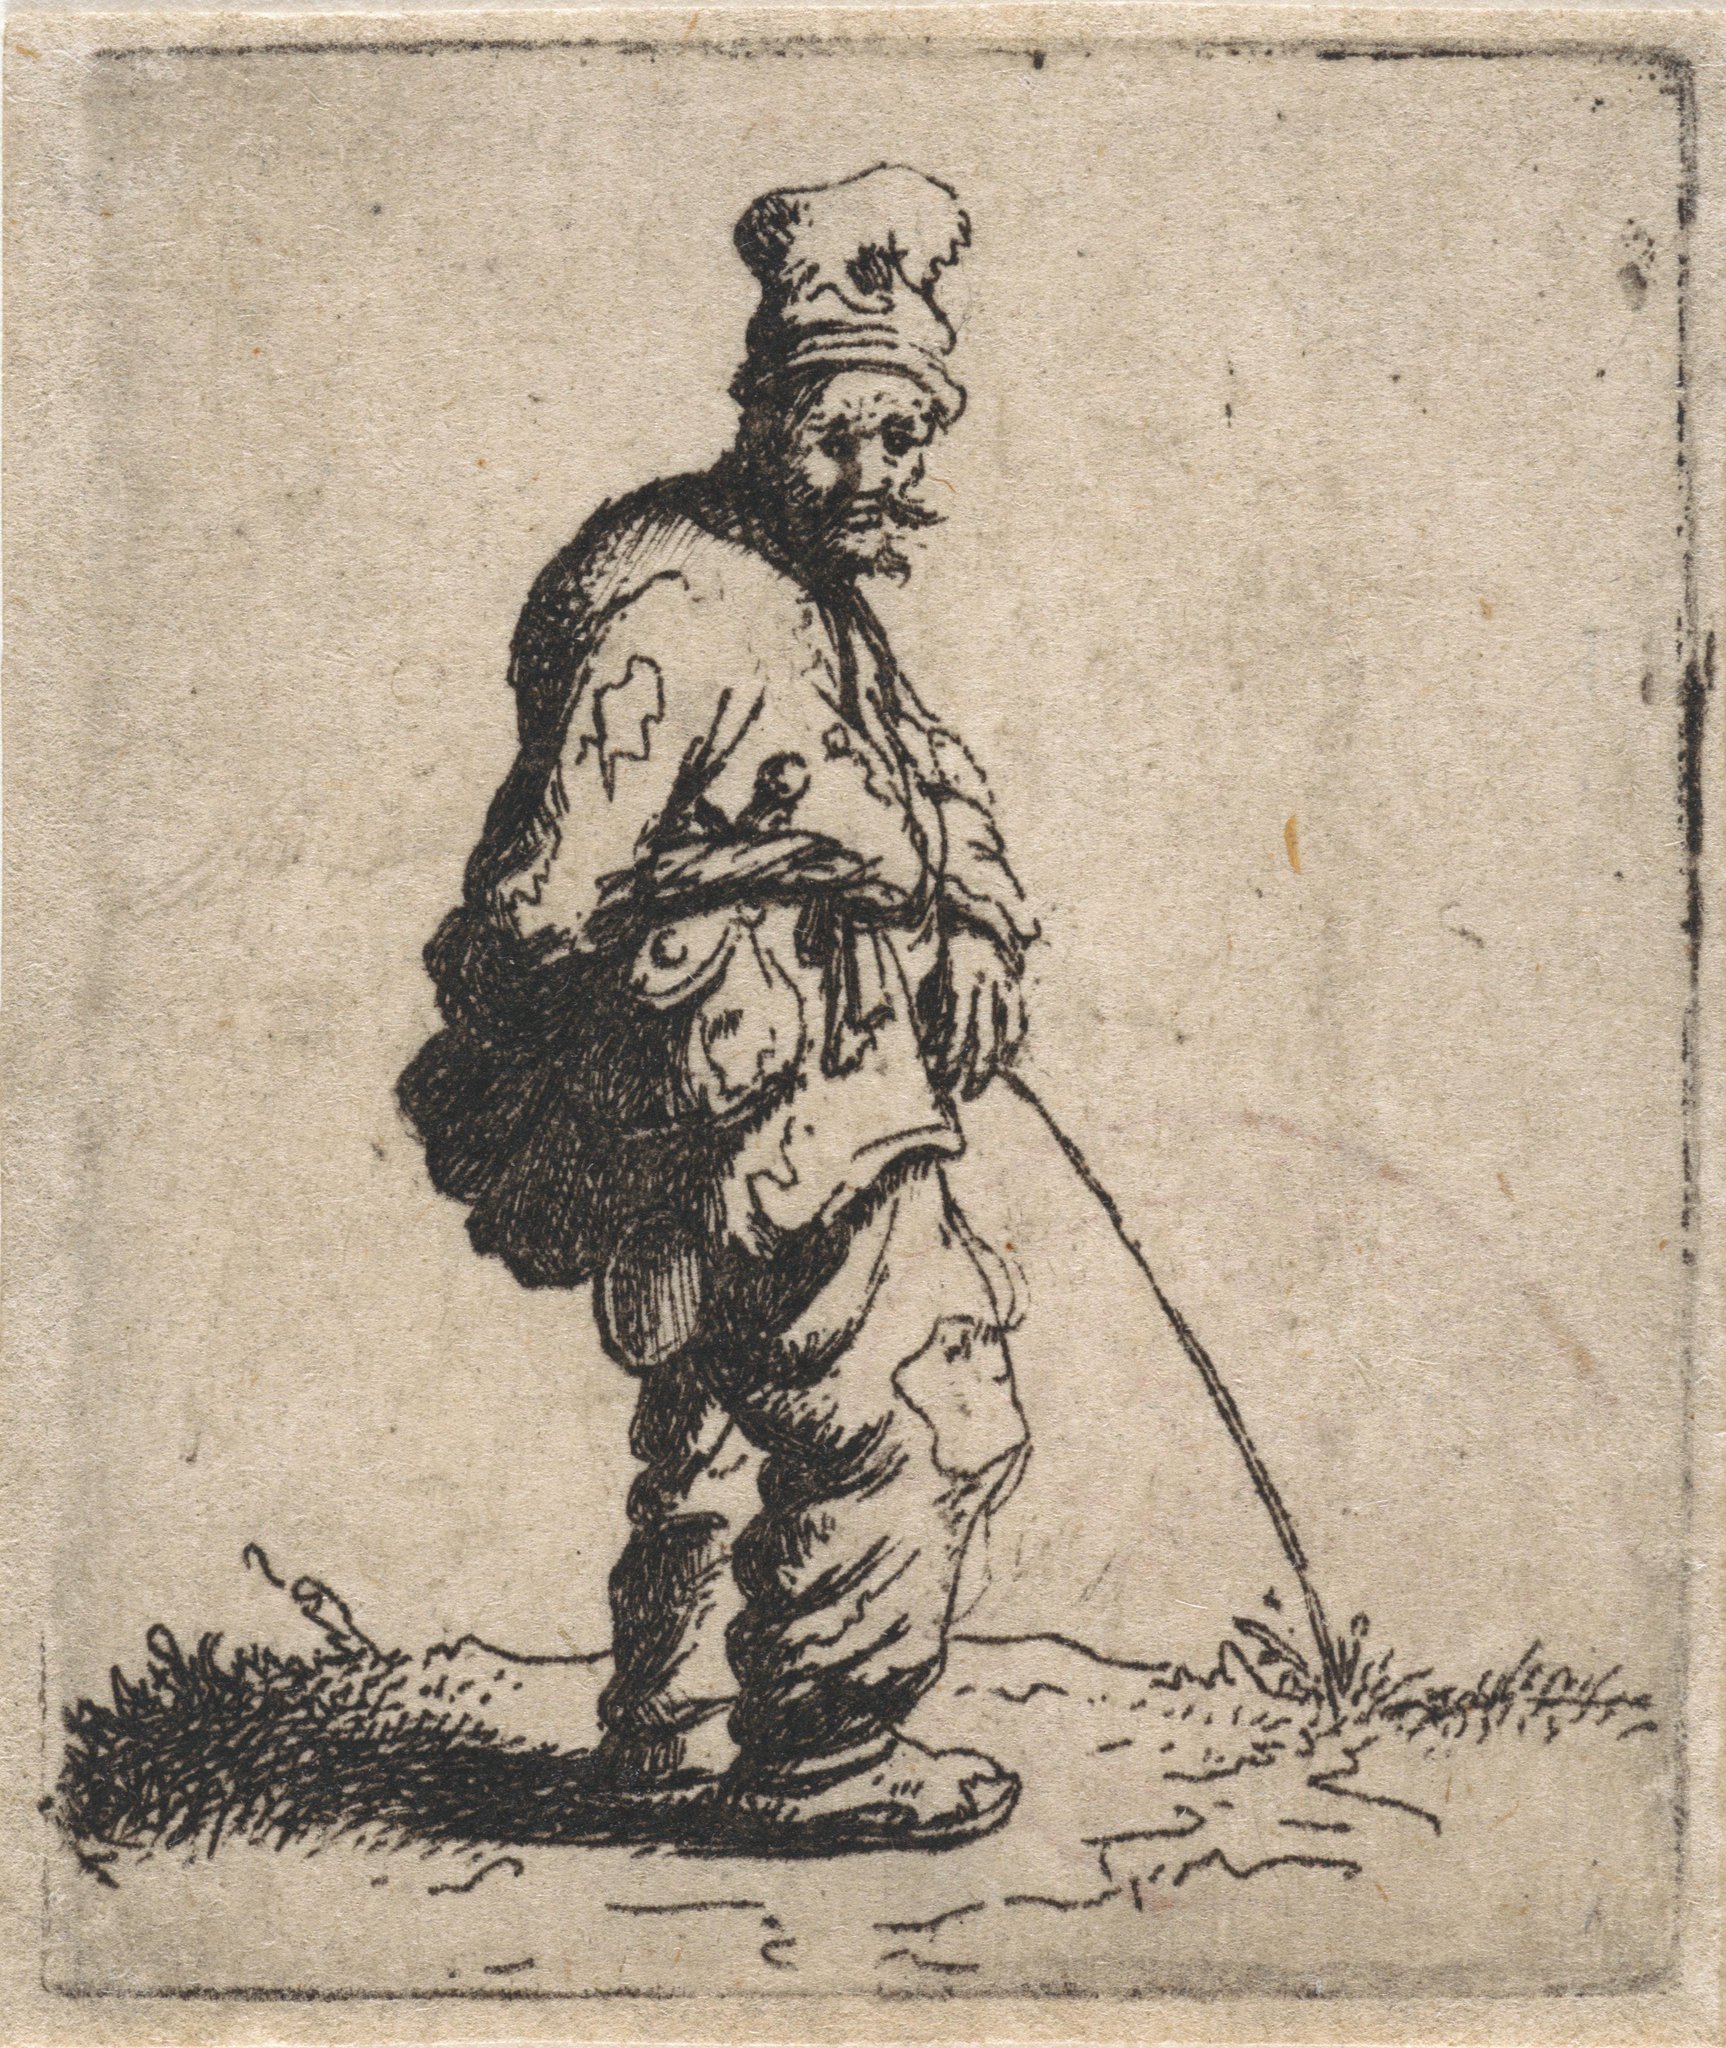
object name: print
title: Waterende man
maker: jan gillisz. van vliet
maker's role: draughtsman, painter, print maker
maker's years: 1600-1668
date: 1632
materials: paper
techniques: etching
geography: leiden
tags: urination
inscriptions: collector's mark: Lugt 240